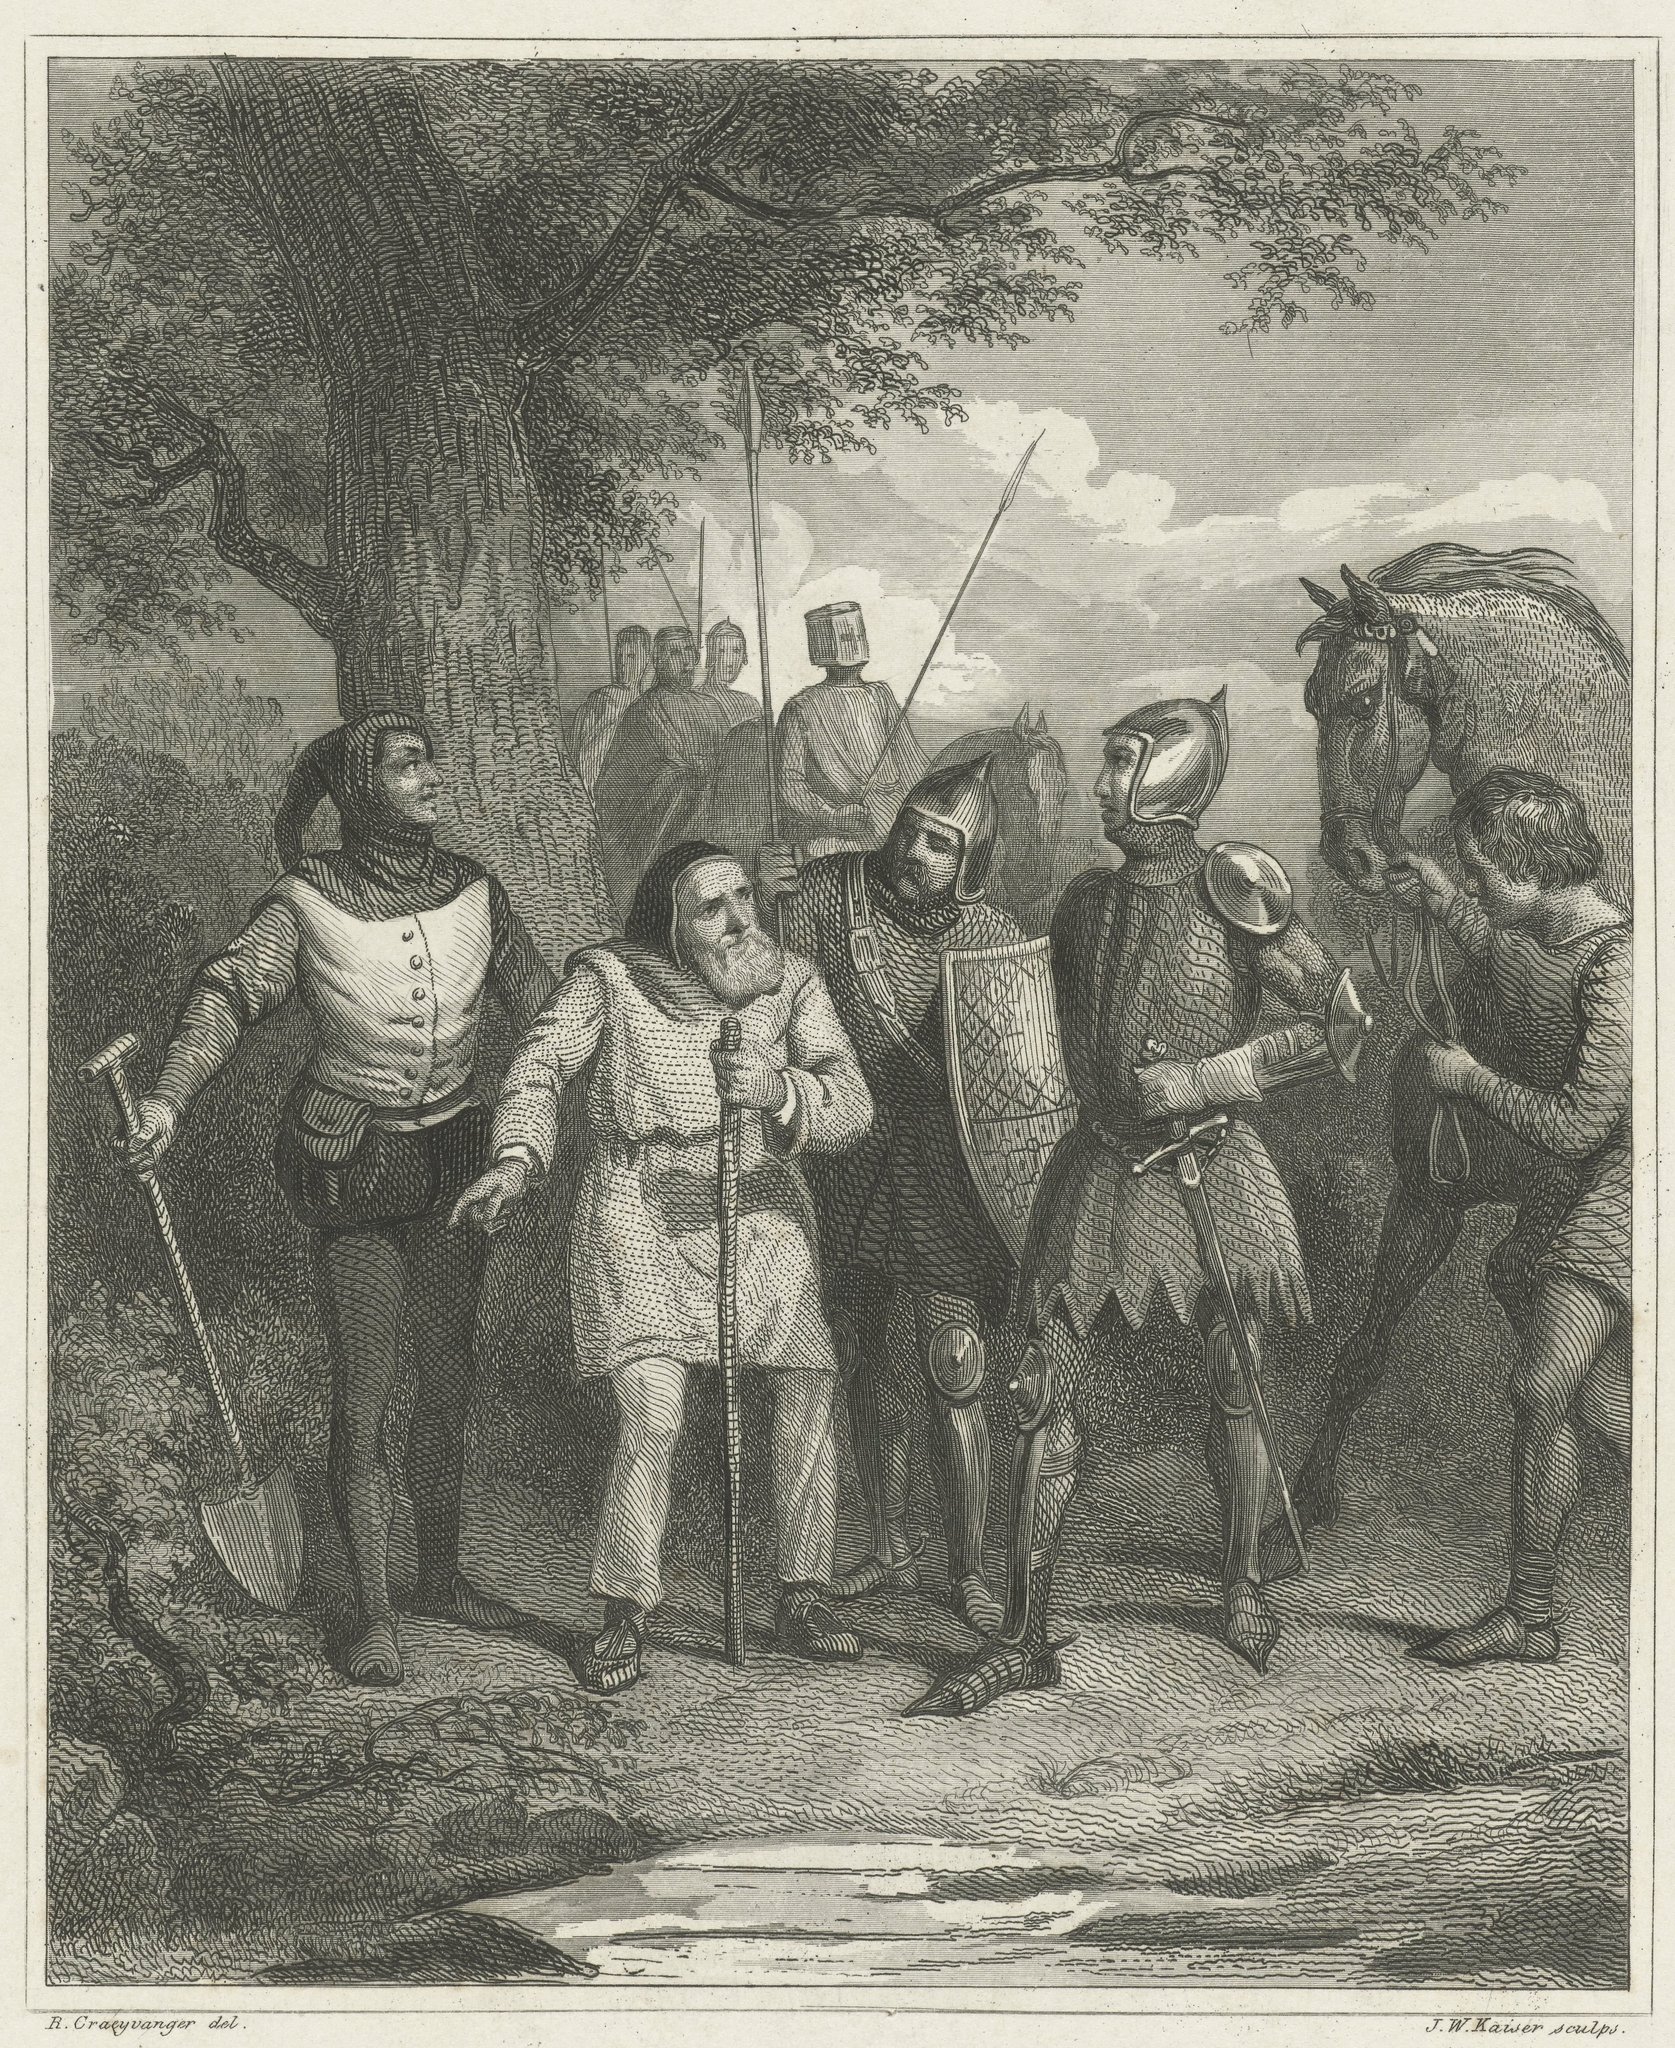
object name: print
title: Een Fries openbaart aan graaf Floris V waar zich het lijk van koning Willem bevindt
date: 1839-1841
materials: paper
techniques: engraving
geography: netherlands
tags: leiden, floris v (graaf van holland en zeeland), earl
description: Illustratie voor: J.P. Arend, Algemeene geschiedenis des vaderlands, Amsterdam, 5 delen, 1840-1882, dl. 2.1, p. 347.